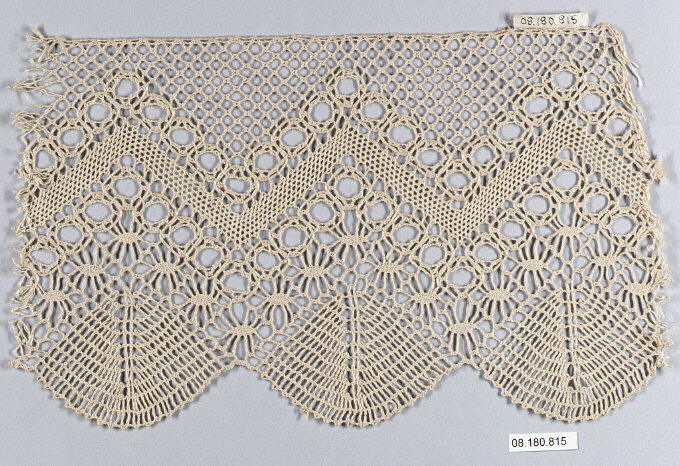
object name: fragment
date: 1801-1900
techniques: lace